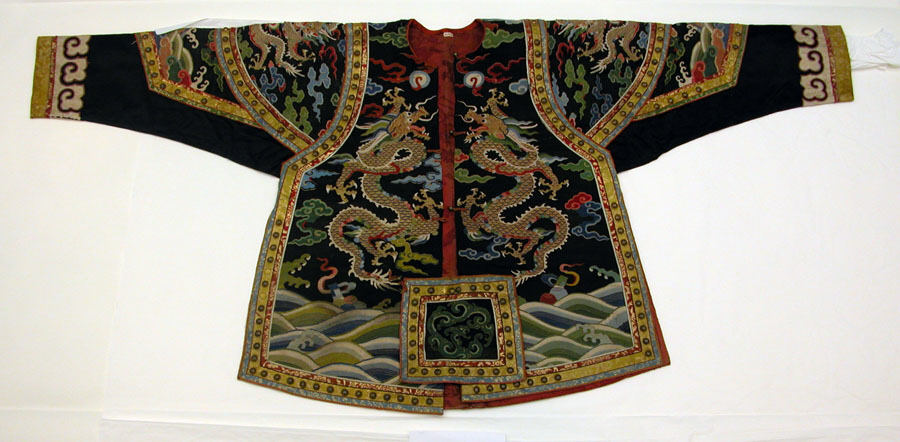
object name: jacket, imperial theatrical, for warrior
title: Theatrical armor with dragons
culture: chinese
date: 1701-1800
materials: metal thread, silk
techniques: tapestry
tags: armor